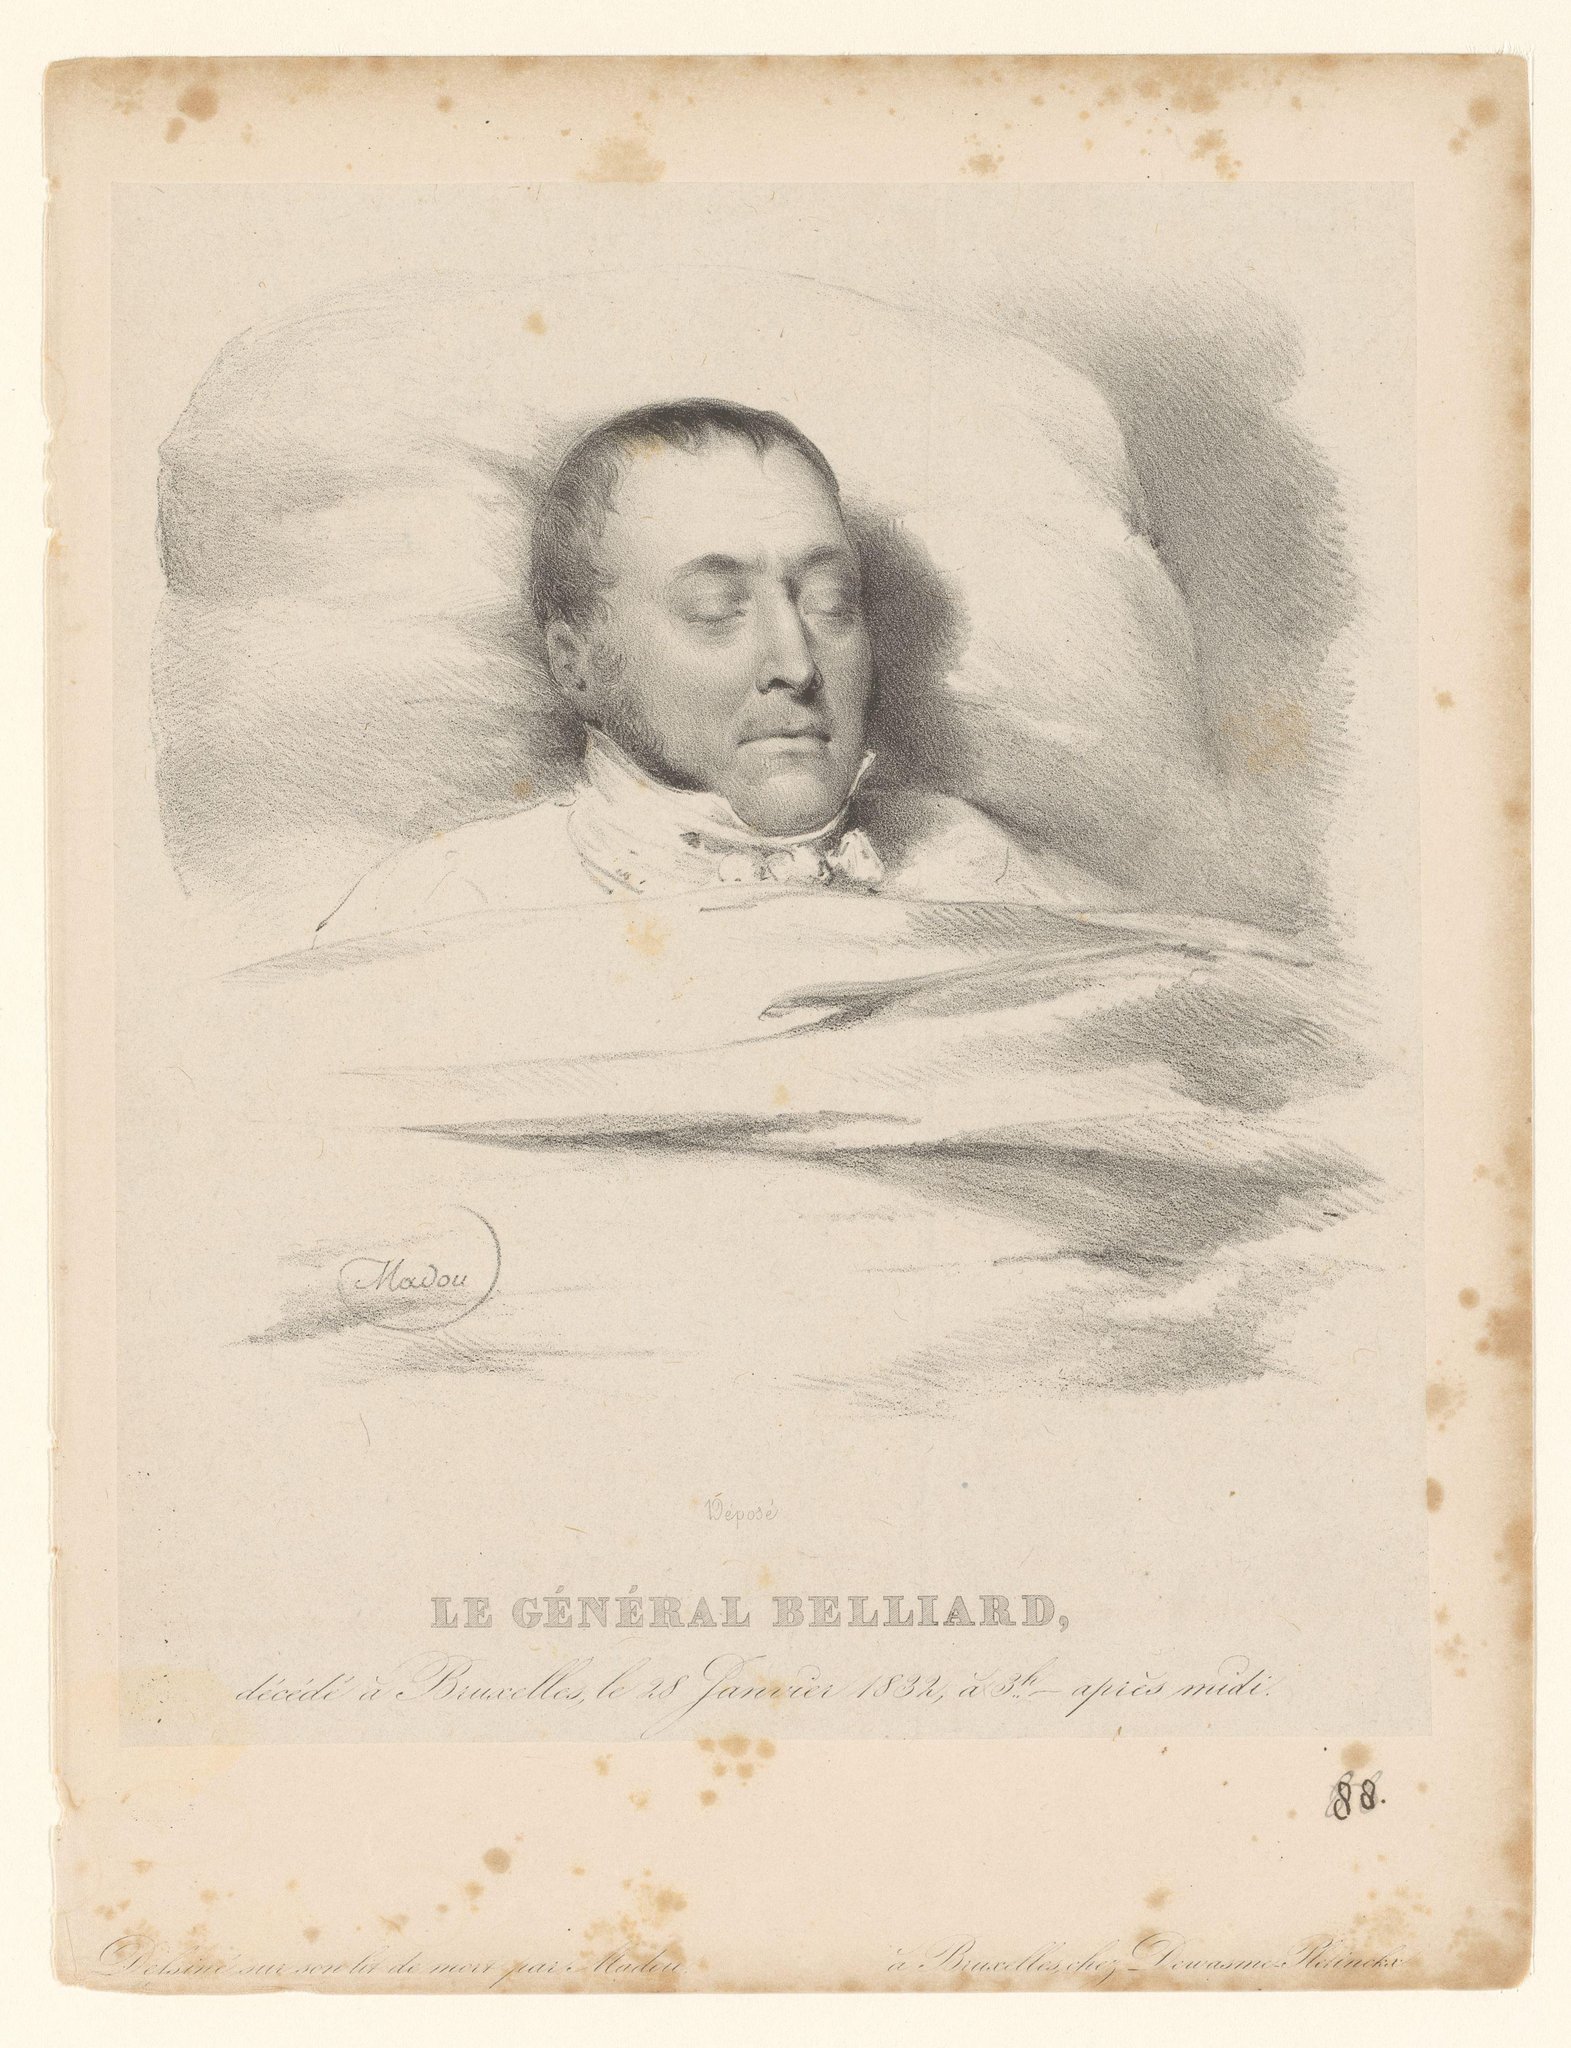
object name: print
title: Doodsportret van Augustin Daniel Belliard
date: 1832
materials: paper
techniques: lithograph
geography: brussels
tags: brussels, adult man, historical persons, death of human being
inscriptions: : ‘Déposé’